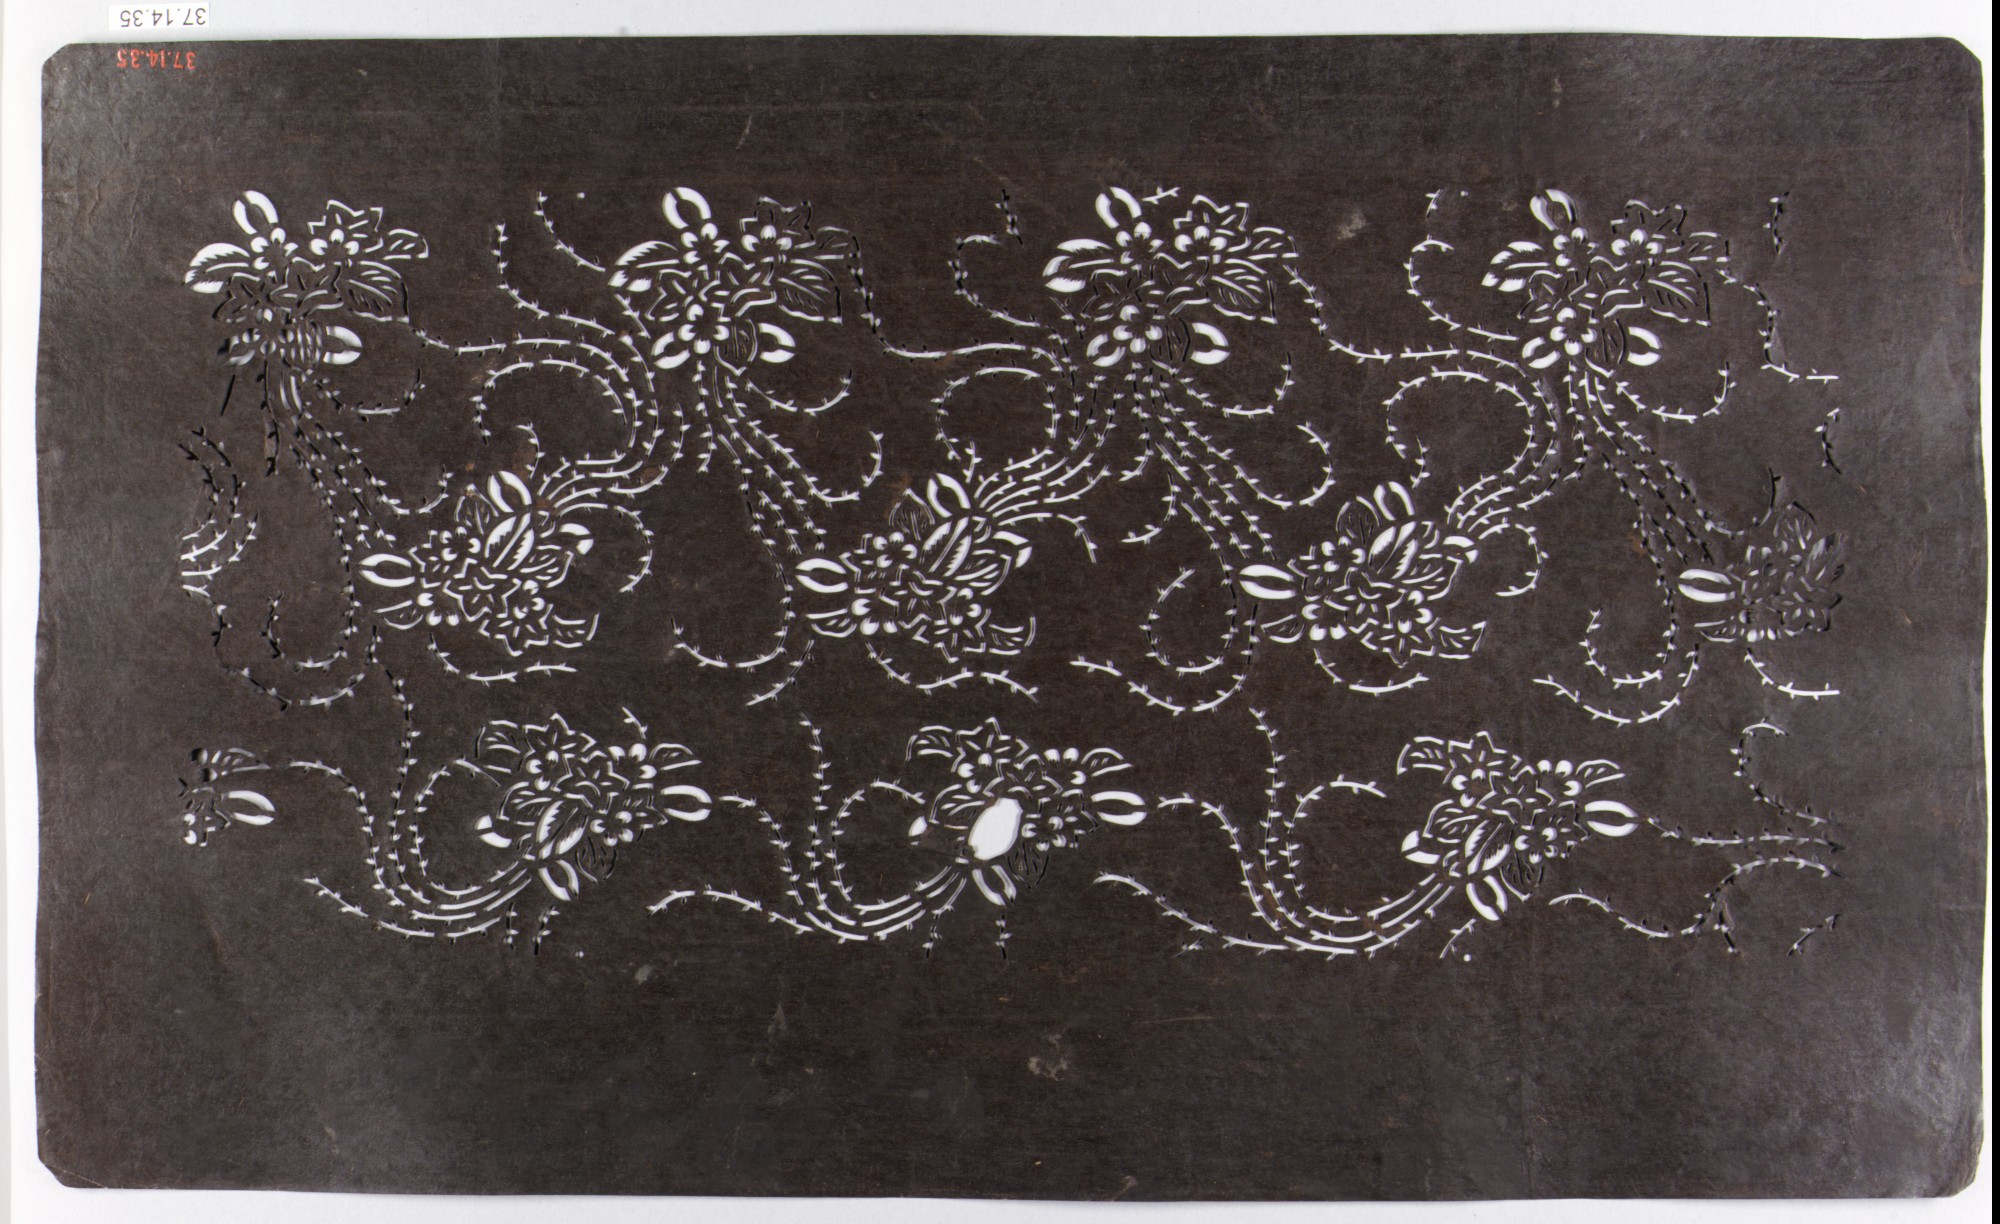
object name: stencil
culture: japanese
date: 1801-1833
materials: paper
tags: flowers